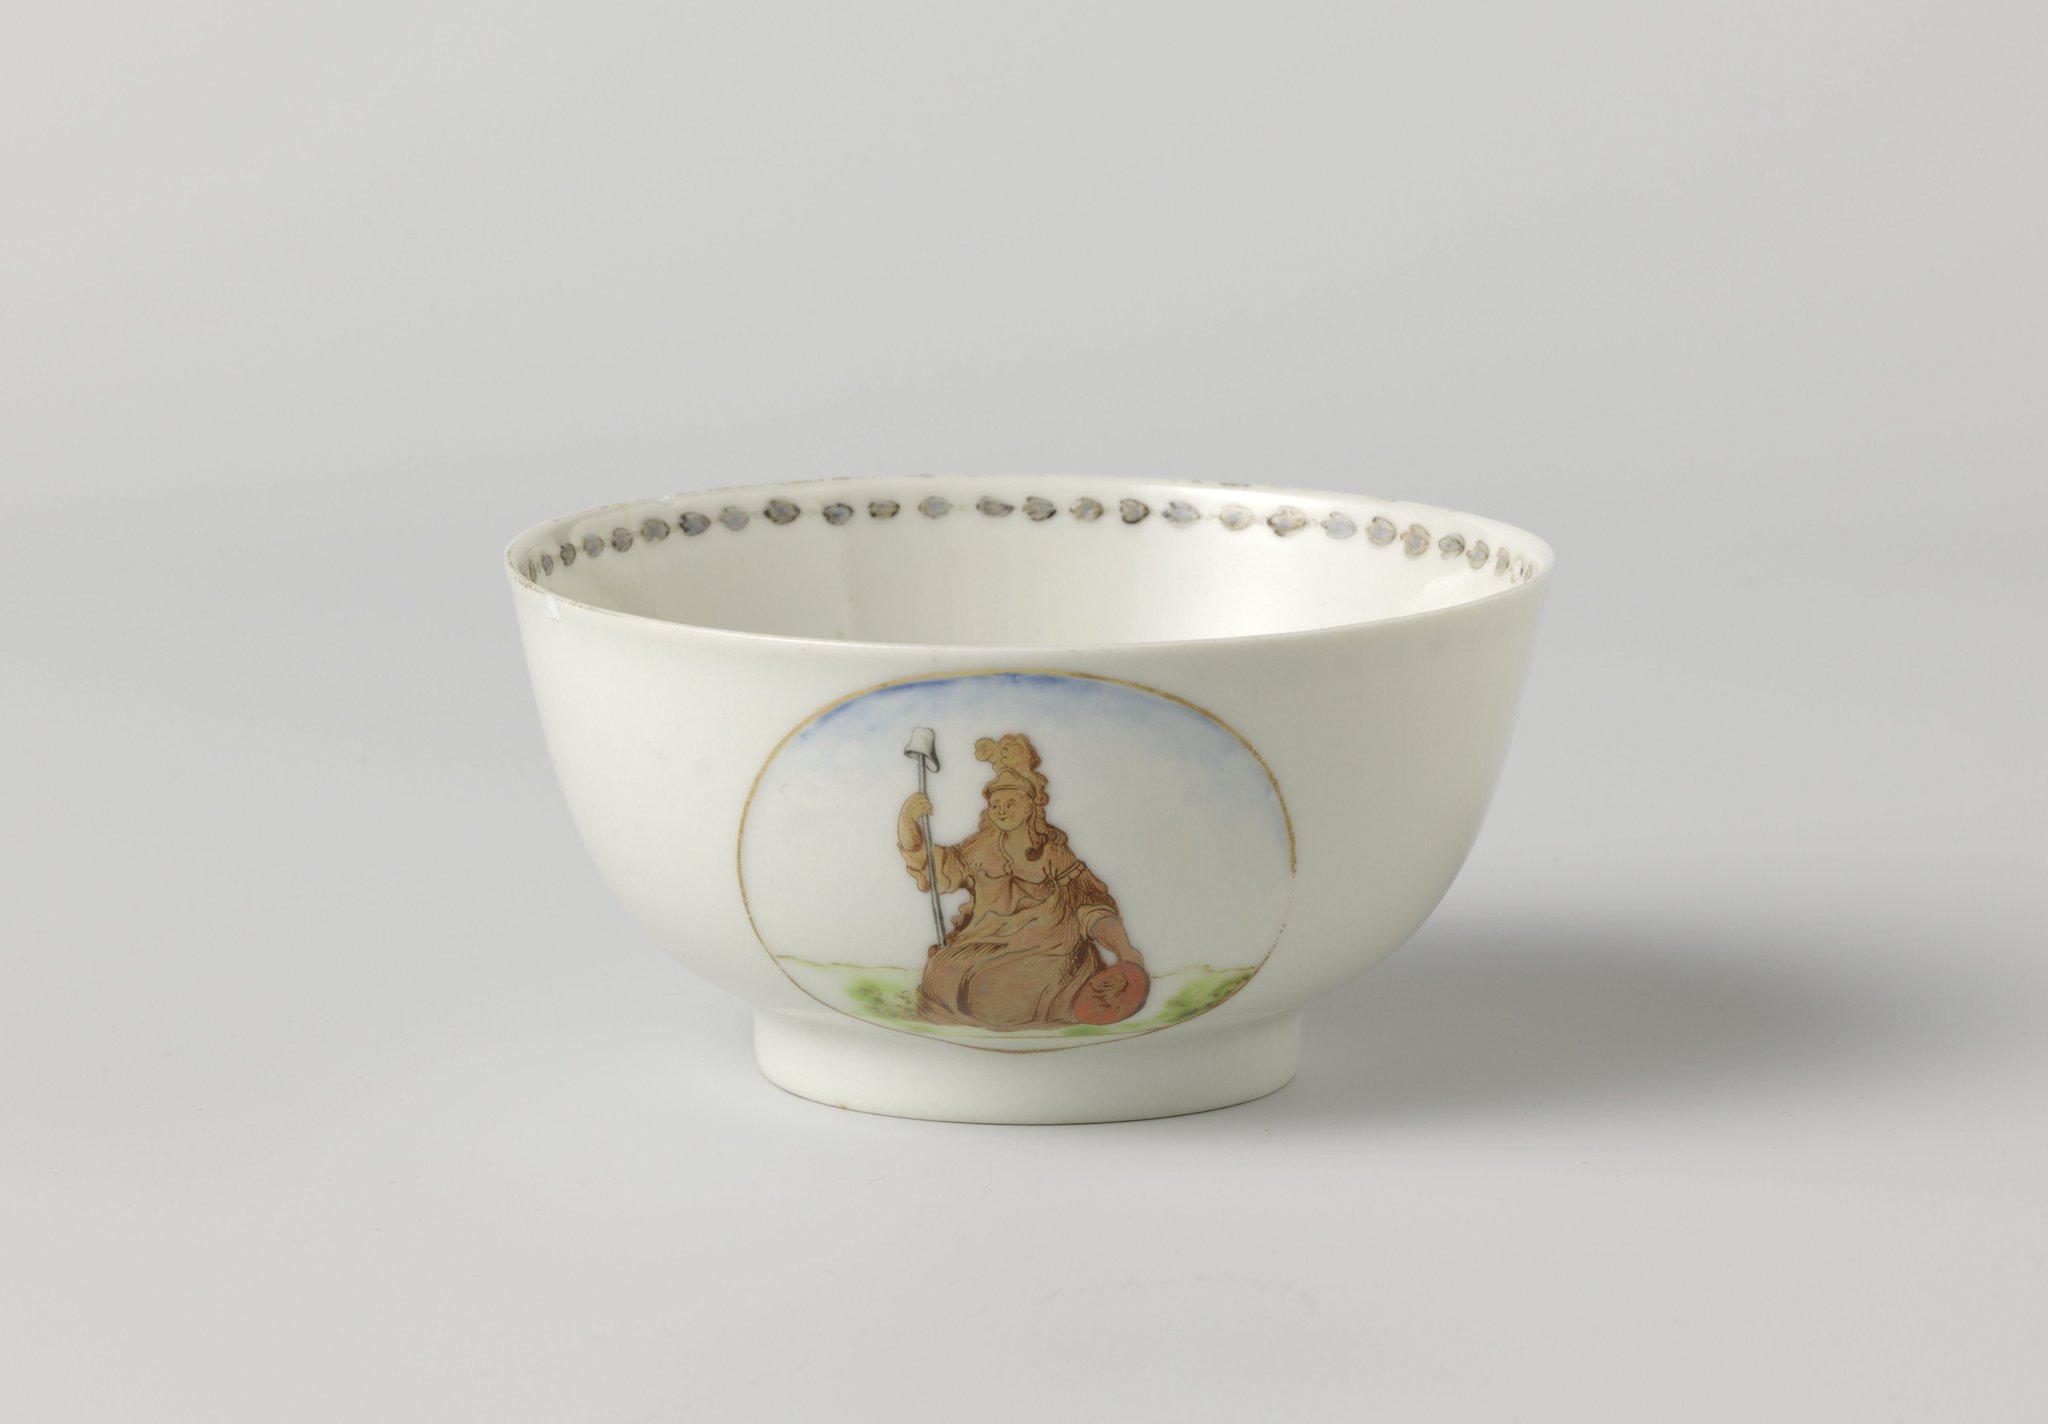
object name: bowl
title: Straight-sided bowl with a Dutch Liberty in a medallion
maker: Anonymous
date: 1795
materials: glaze, gold, paint, porcelain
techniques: firing, gilding, turning, vitrification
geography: china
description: Kom op een voetring, gedecoreerd in emailkleuren. Op de zijden twee ronde velden met een afbeelding van een Hollandse Vrijheidsmaagd. Een schild en speer in haar handen. Aan de binnenkant een decoratief patroon op de rand. Het porseleinen object heeft een historische lading: de late 18de eeuw was een periode van grote onrust in Nederland waarbij twee partijen tegenover elkaar stonden: de Frans georiënteerde patriotten en de Hollands georiënteerde Orangisten. Na de Franse overwinning op Nederland in 1795 namen de patriotten een leidende rol. Het symbool dat zij voerden was de Vrijheidsmaagd, zoals op deze kom te zien is.